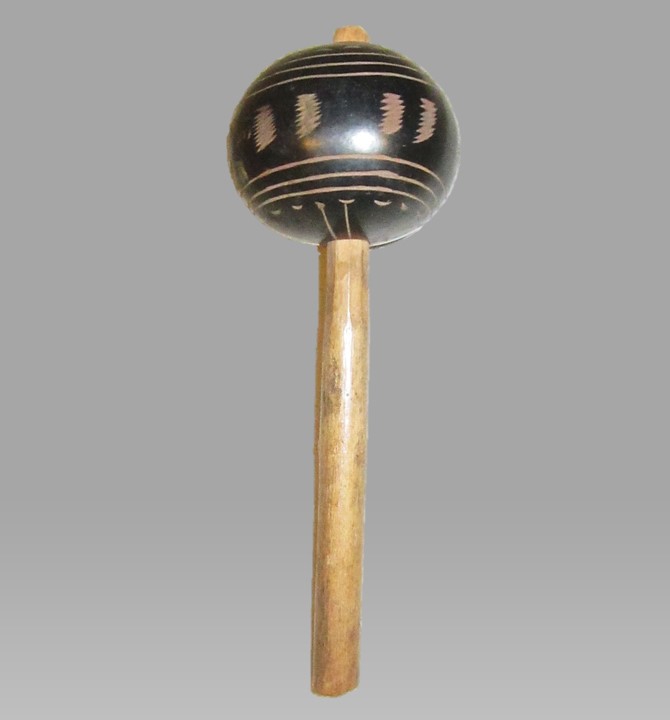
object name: gourd rattle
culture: native american or guyanese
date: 1867-1900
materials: wood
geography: guyana